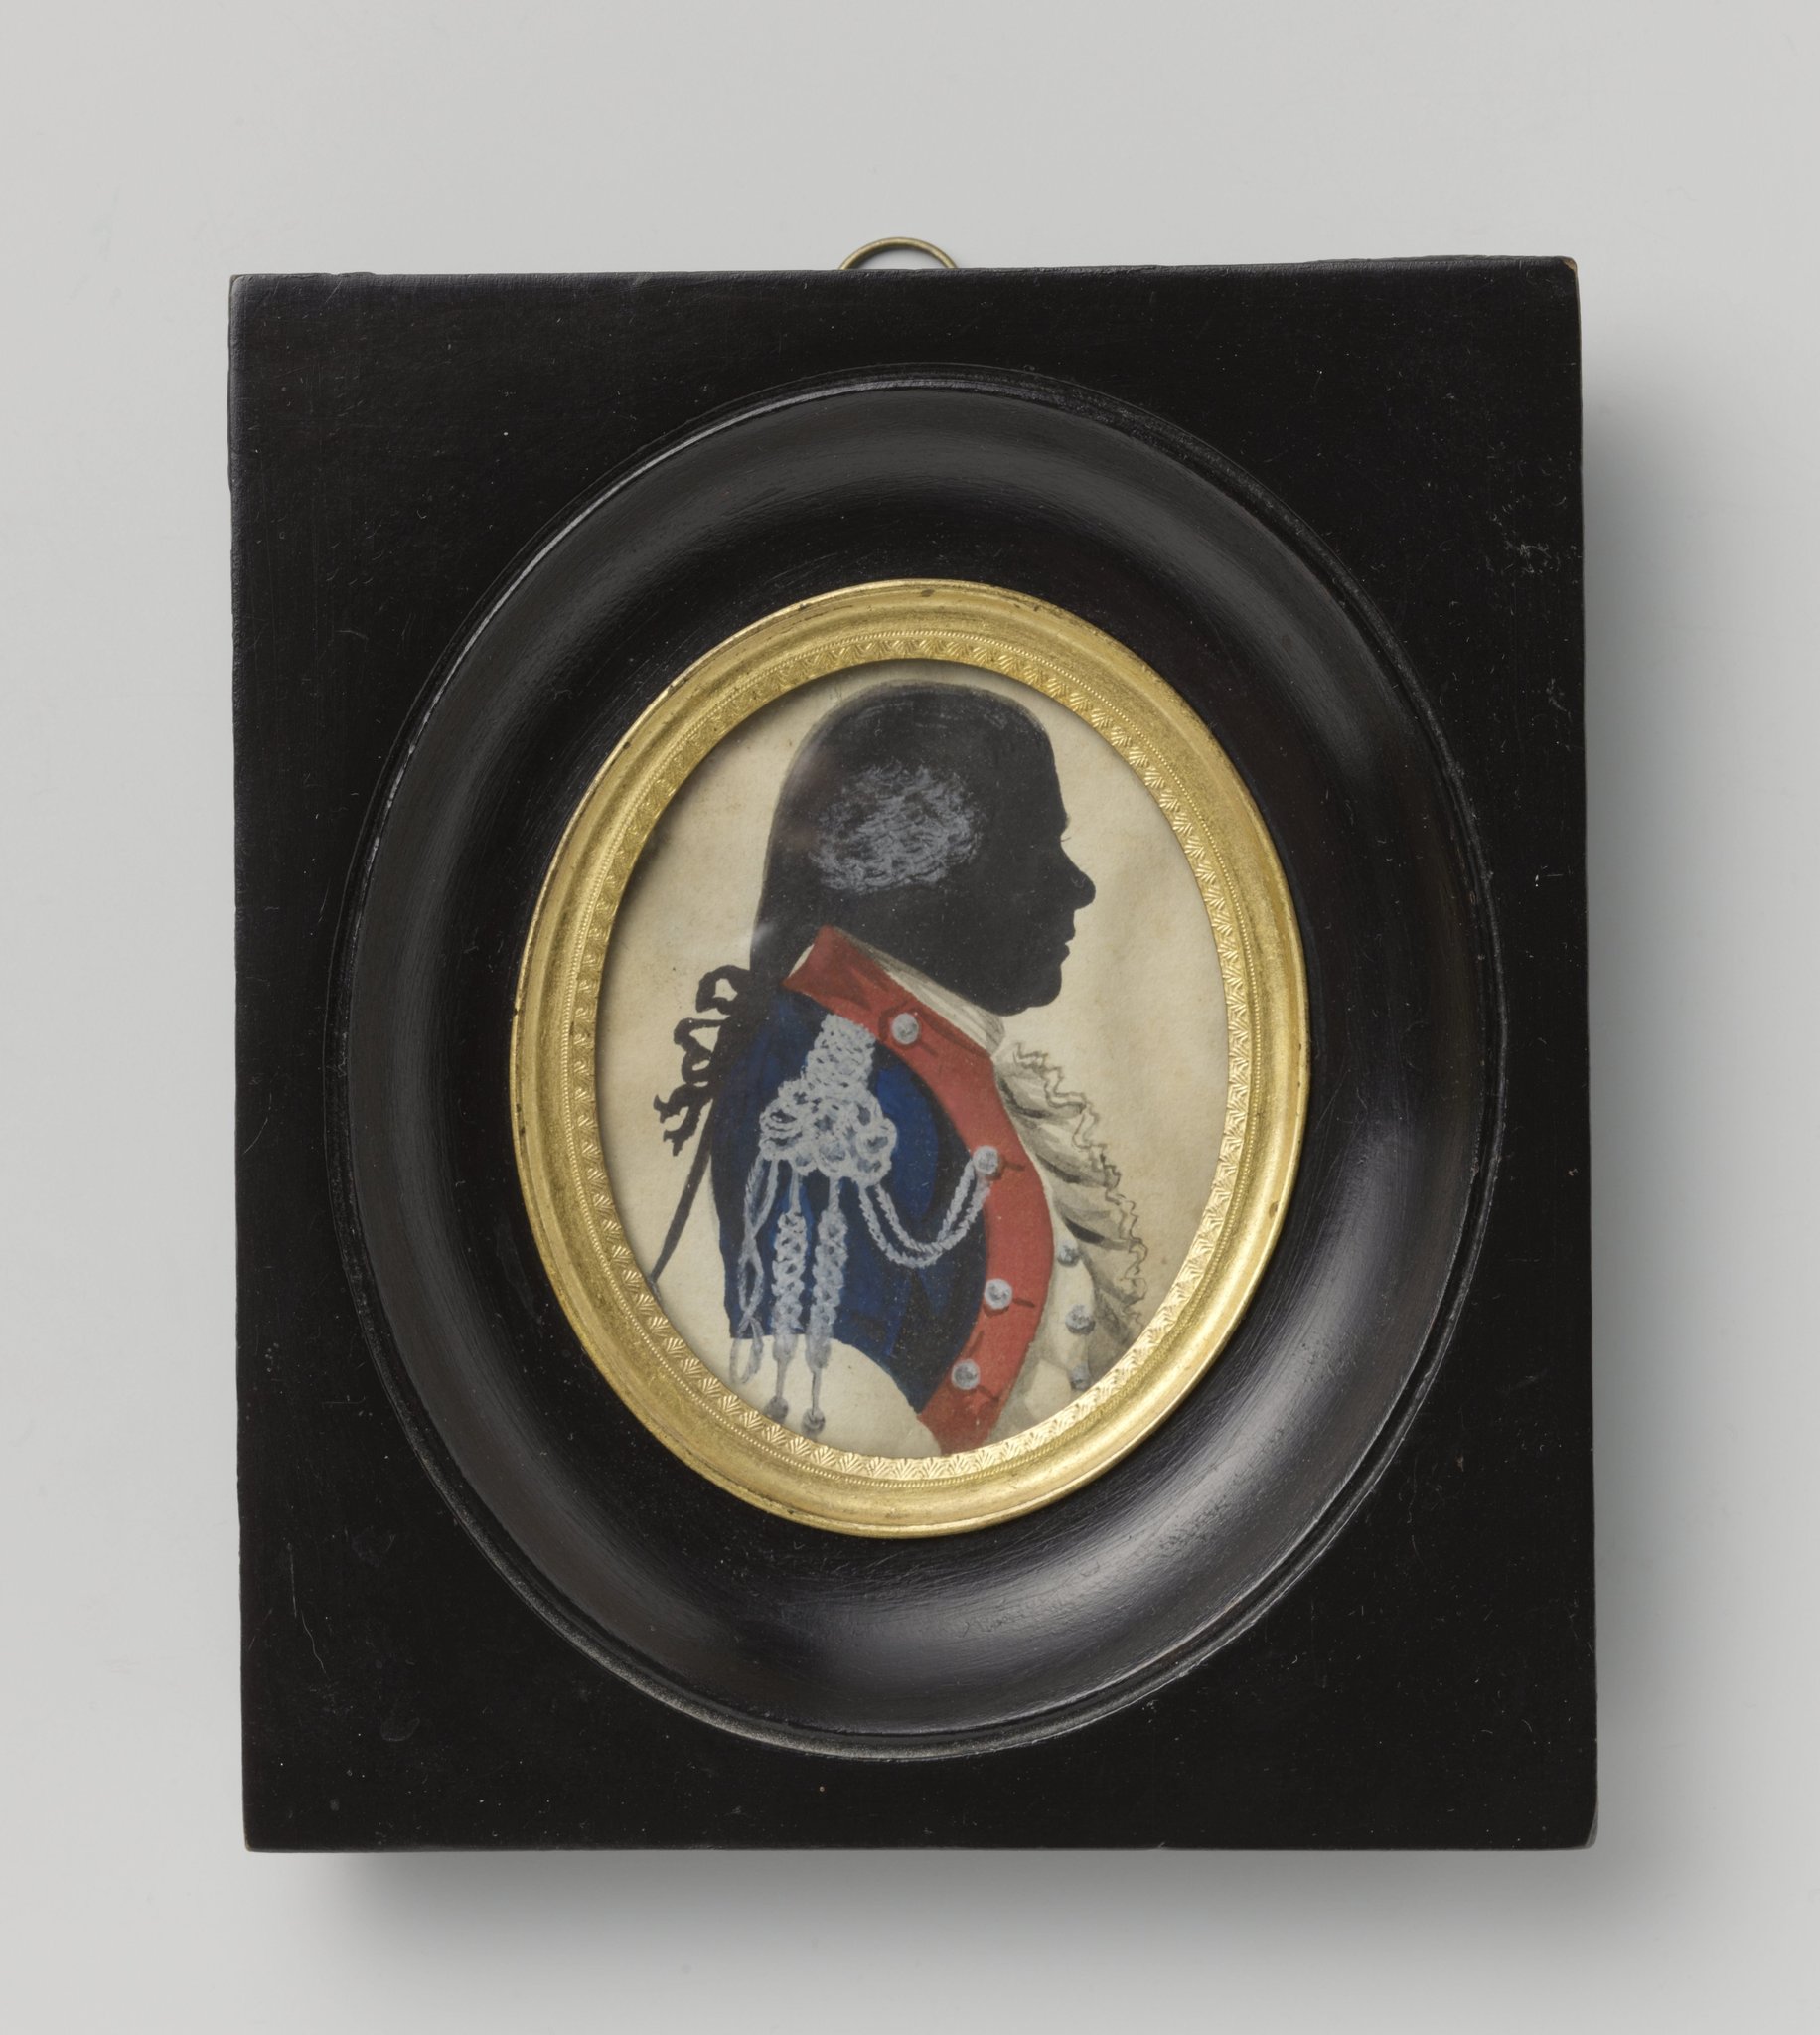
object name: painting, miniature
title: Jacob François de Friderici (1813/14-1847)?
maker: Anonymous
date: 1800-1850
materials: paint, paper, wood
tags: suriname